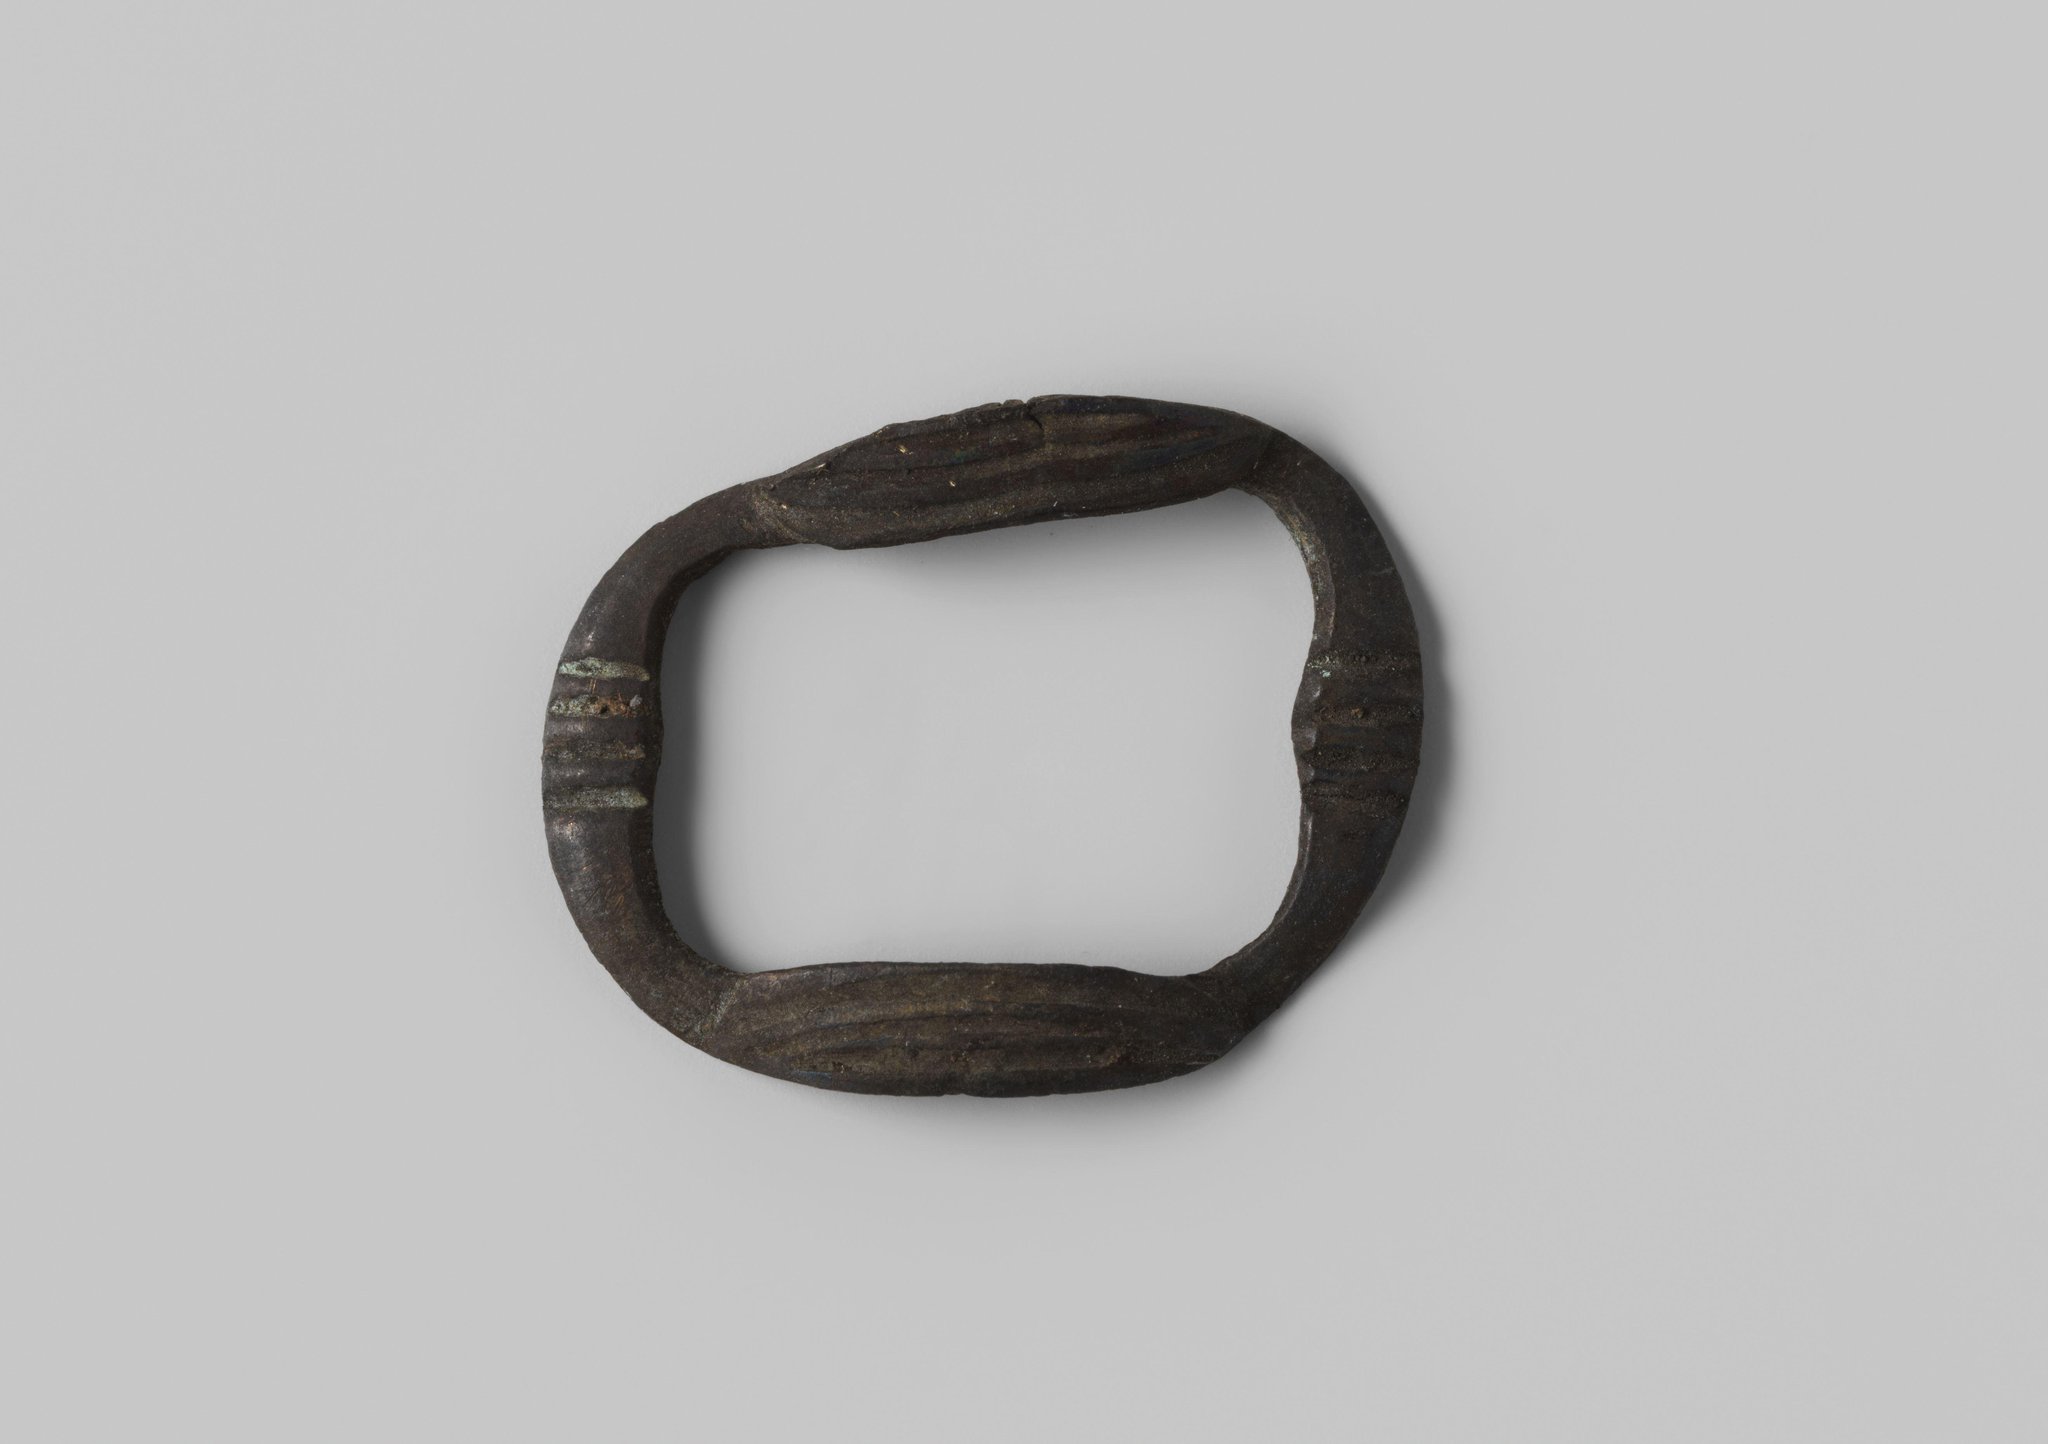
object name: knee buckle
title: Kniegesp uit het wrak van de Oost-Indiëvaarder Hollandia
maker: Anonymous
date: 1700-1743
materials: copper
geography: netherlands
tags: verenigde oostindische compagnie, hollandia (schip), annet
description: Buckle, chape buckle, knee buckle; ring, oval, fluted decoration.